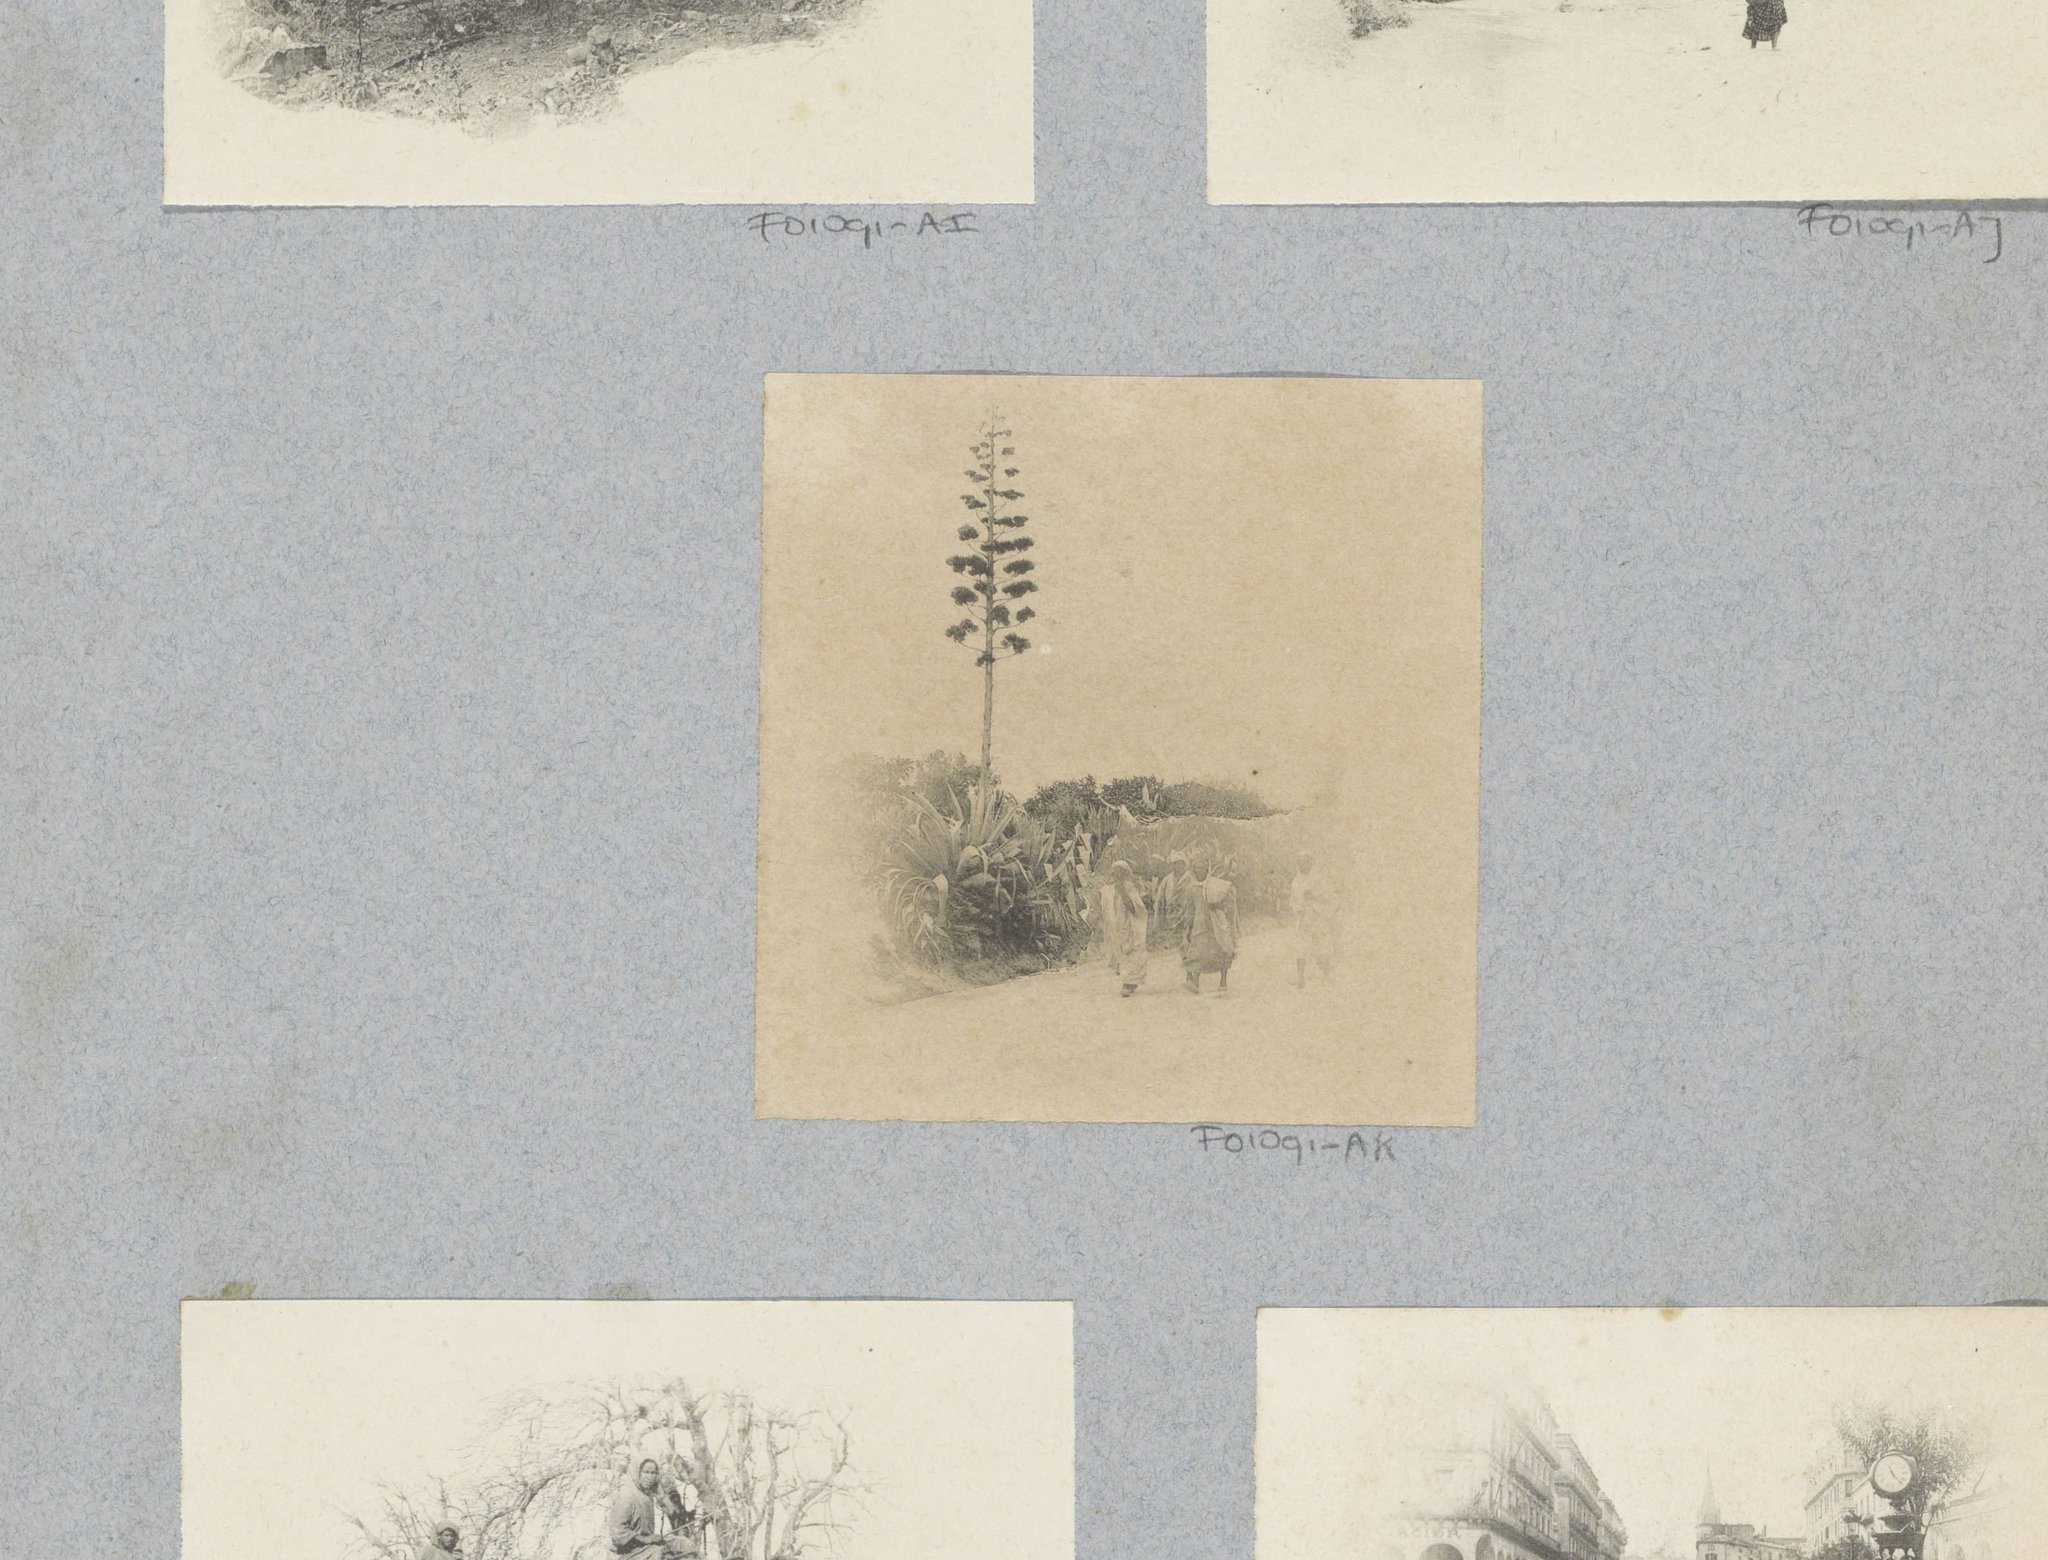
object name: album leaf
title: Tunesische vrouw in een rivier bij palmen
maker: Anonymous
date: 1880-1900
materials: paper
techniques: photograph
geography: tunisia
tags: river (+ landscape with figures, staffage)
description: Onderdeel van Reisalbum met foto's van bezienswaardigheden in Tunis en Tunesië.